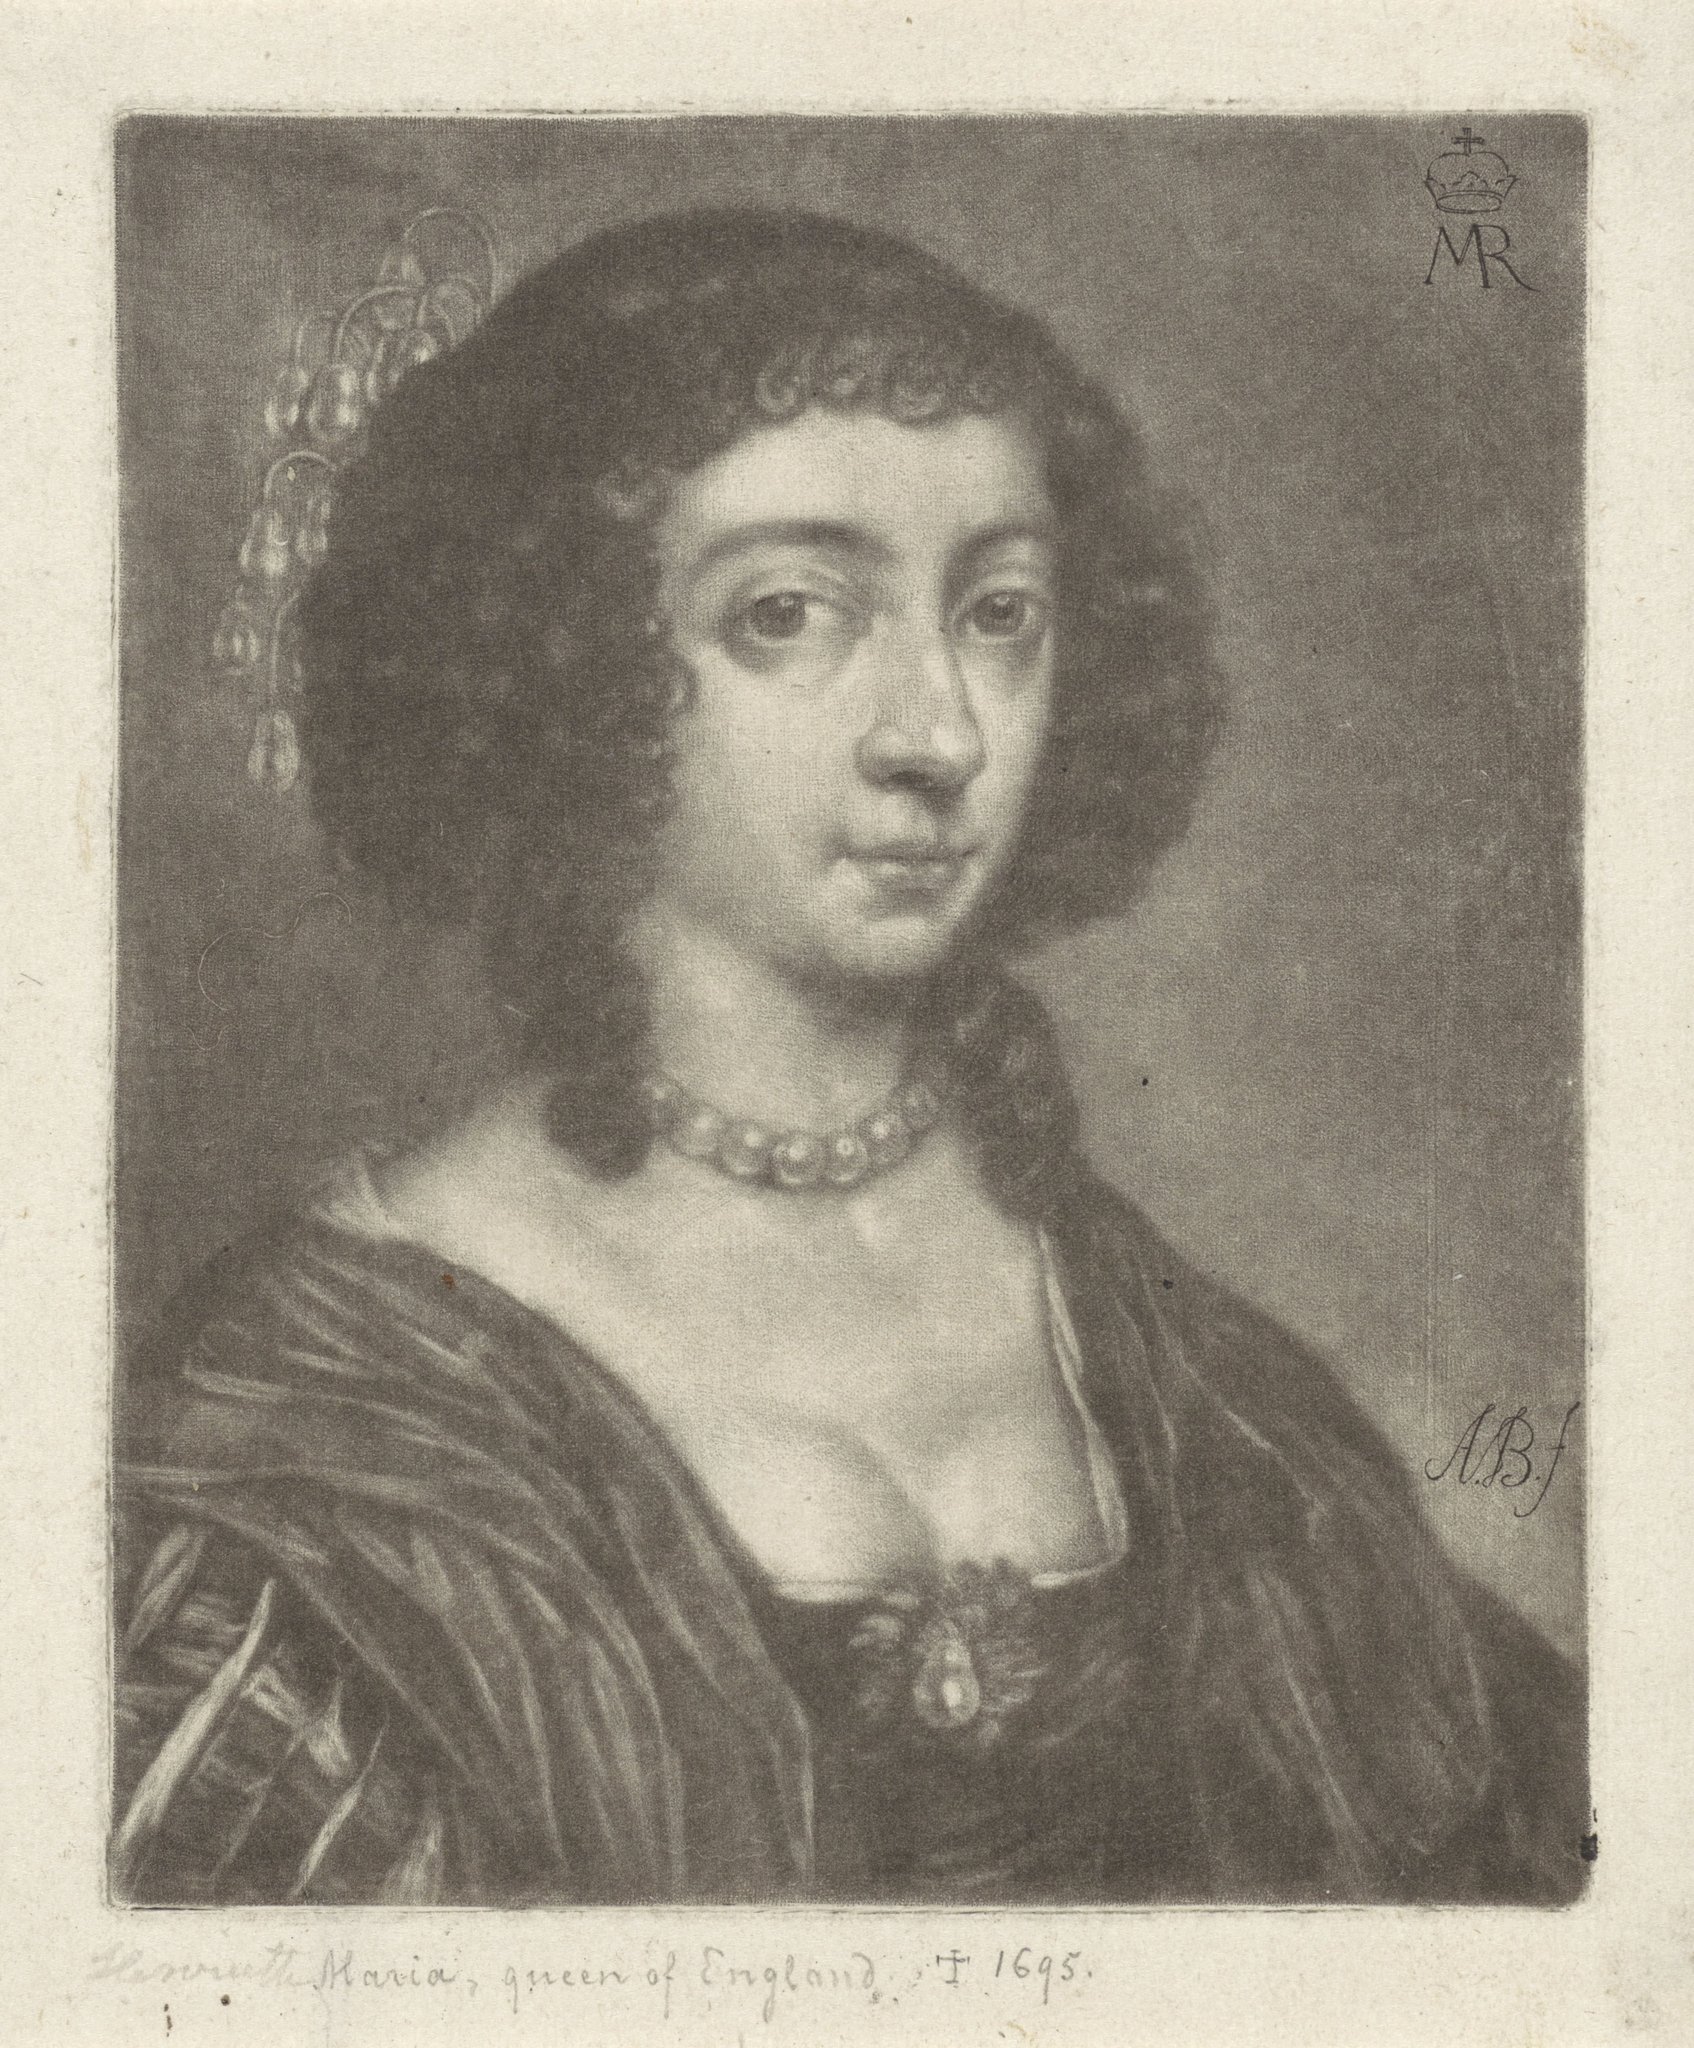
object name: print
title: Portret van Henrietta Maria van Bourbon, koningin van Engeland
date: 1652-1690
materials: paper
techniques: engraving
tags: henriëtta maria van frankrijk (koningin van engeland, schotland en ierland)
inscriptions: inscription: ‘Henrietta Maria, queen of England + 1695.’, collector's mark: Lugt 2228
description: Portret van Henrietta Maria van Bourbon, koningin van Engeland, echtgenote van Karel I, koning van Engeland.